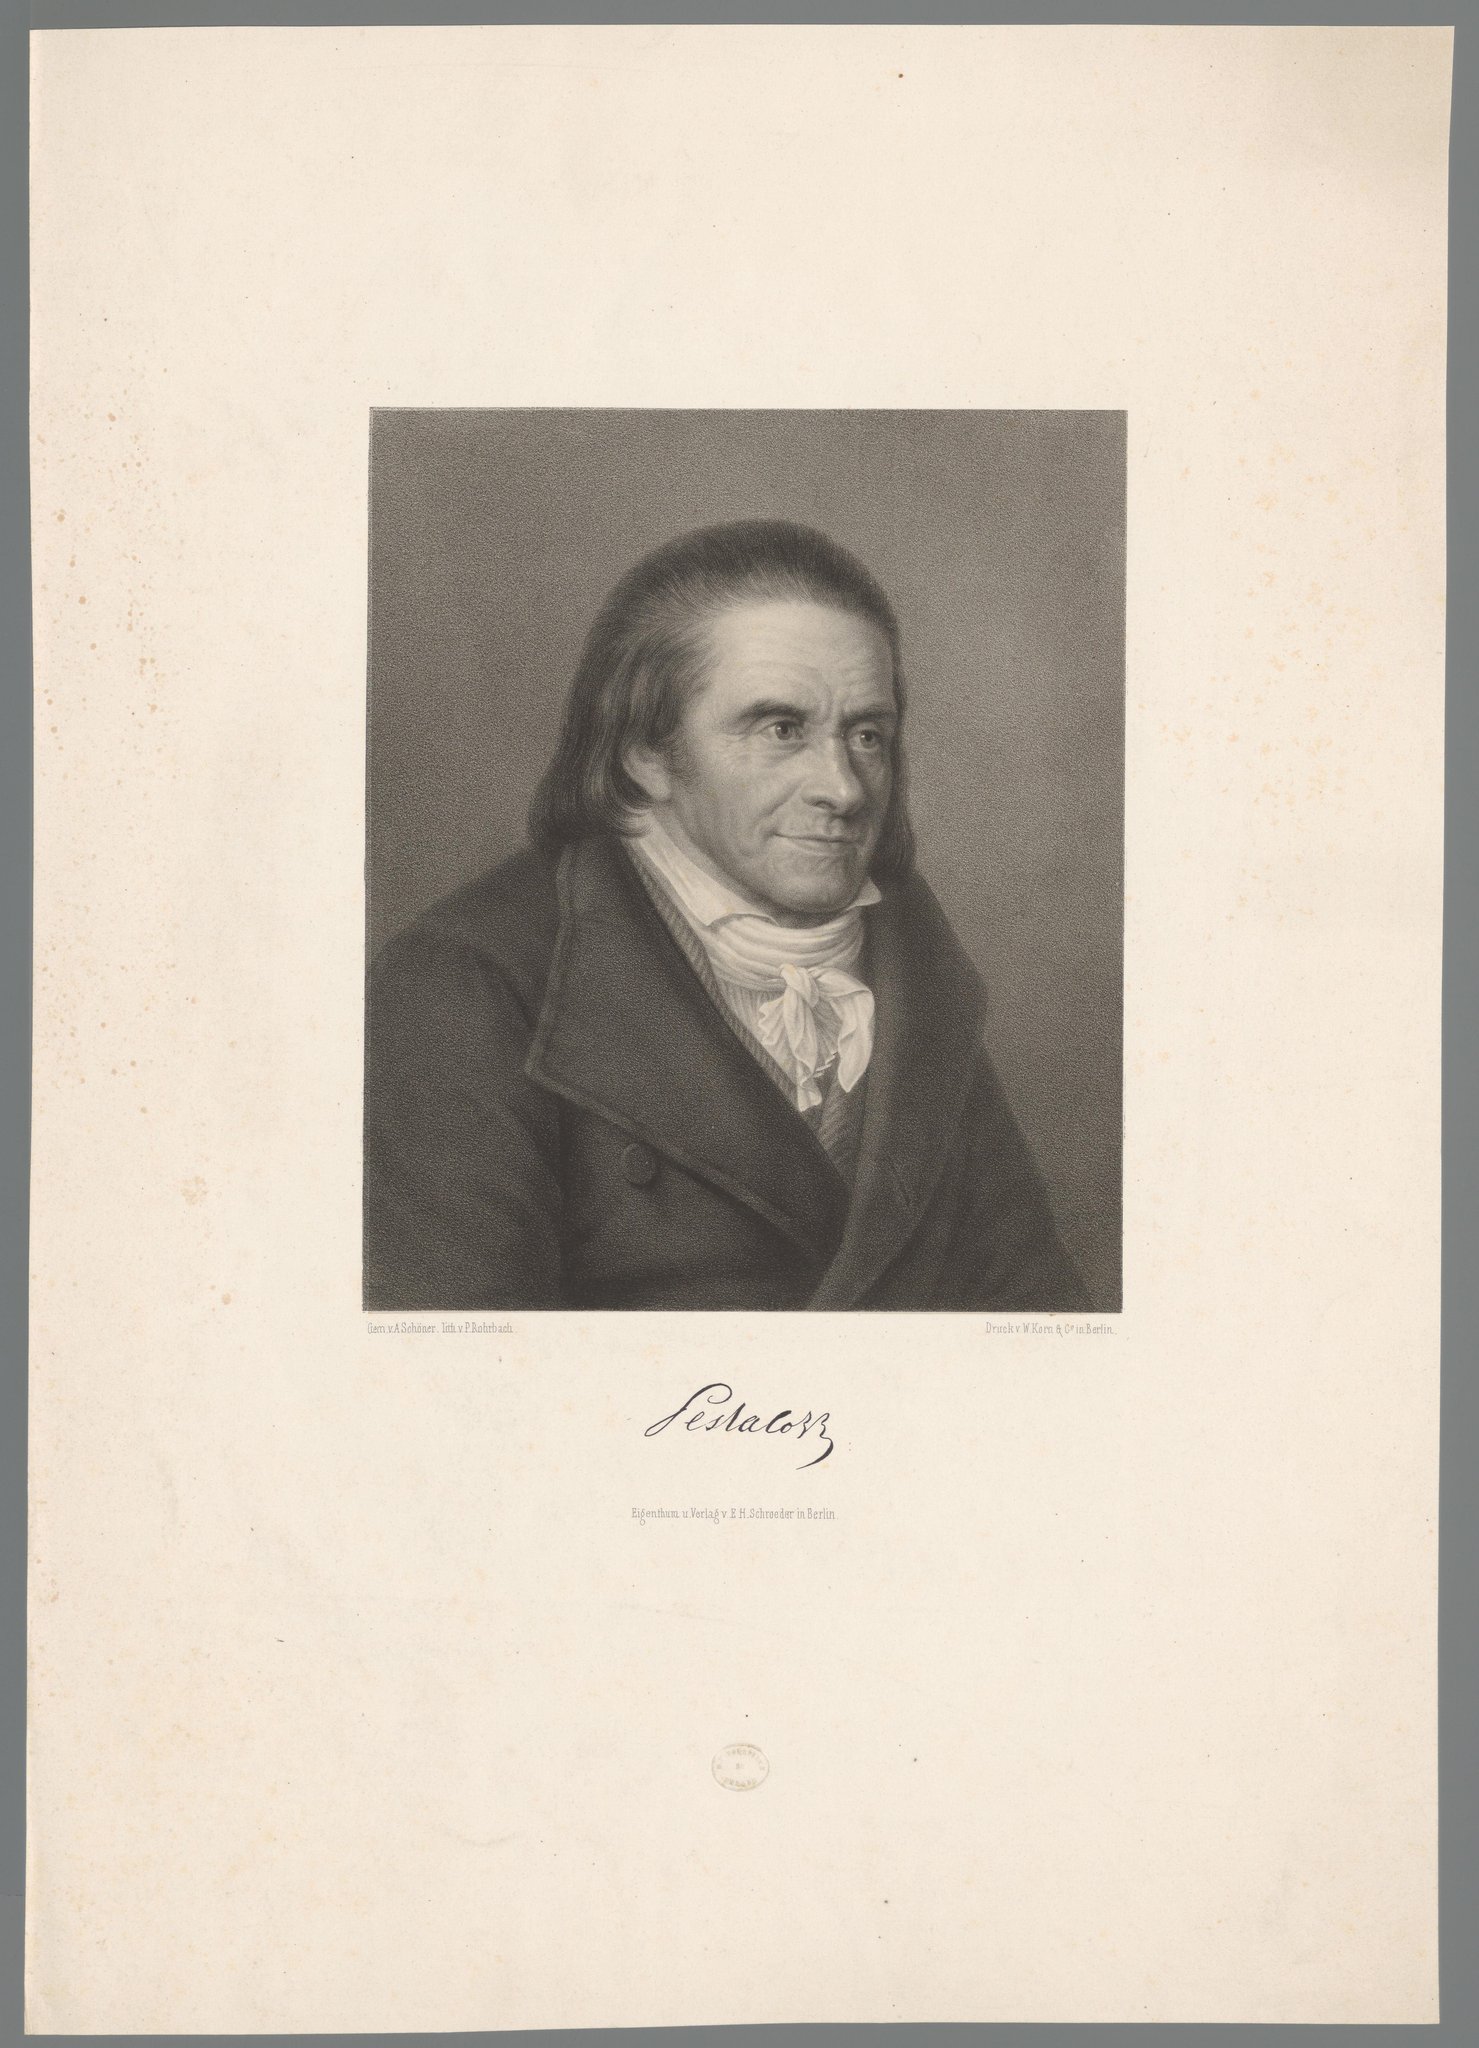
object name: print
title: Portret van Johann Heinrich Pestalozzi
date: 1827-1849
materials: paper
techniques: lithograph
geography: berlin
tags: politician, historical persons, portrait of a writer, politician, e.g. party leader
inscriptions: collector's mark: Lugt 2228, check stamp: Lugt 5326